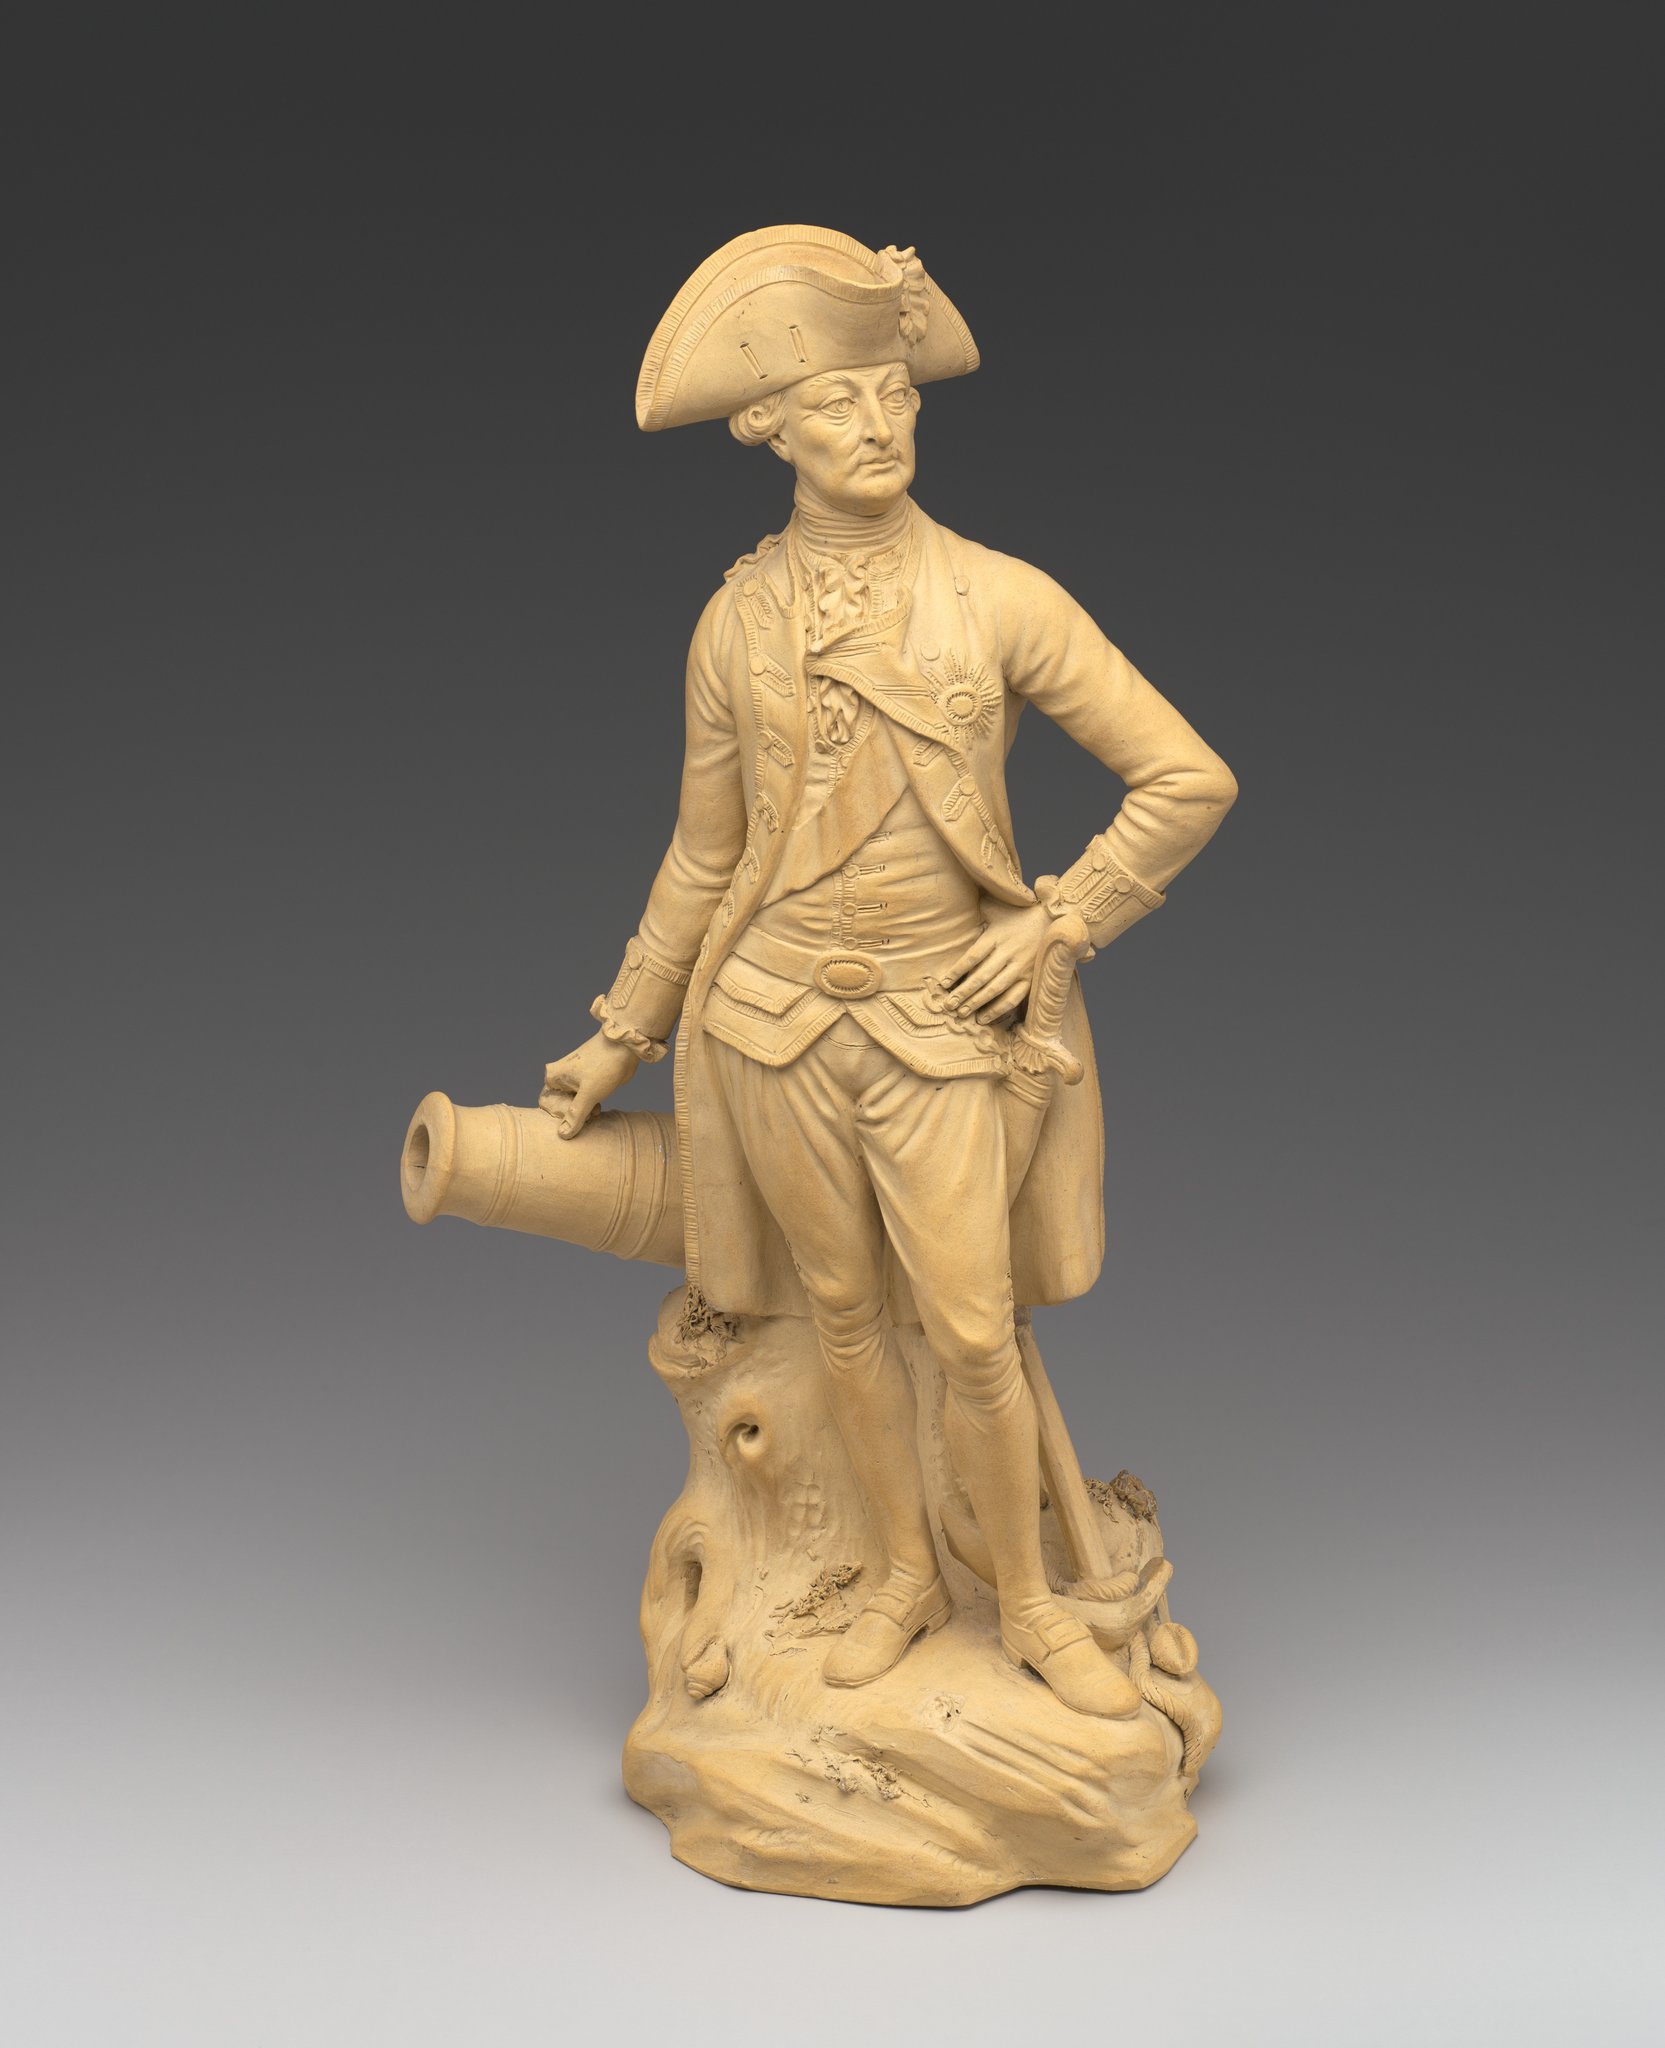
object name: figure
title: George Brydges Rodney (1718–1792), 1st Baron, English admiral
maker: pierre stephan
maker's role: modeler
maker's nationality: french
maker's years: 1765-1795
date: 1701-1800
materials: stoneware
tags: cannons,men,admirals